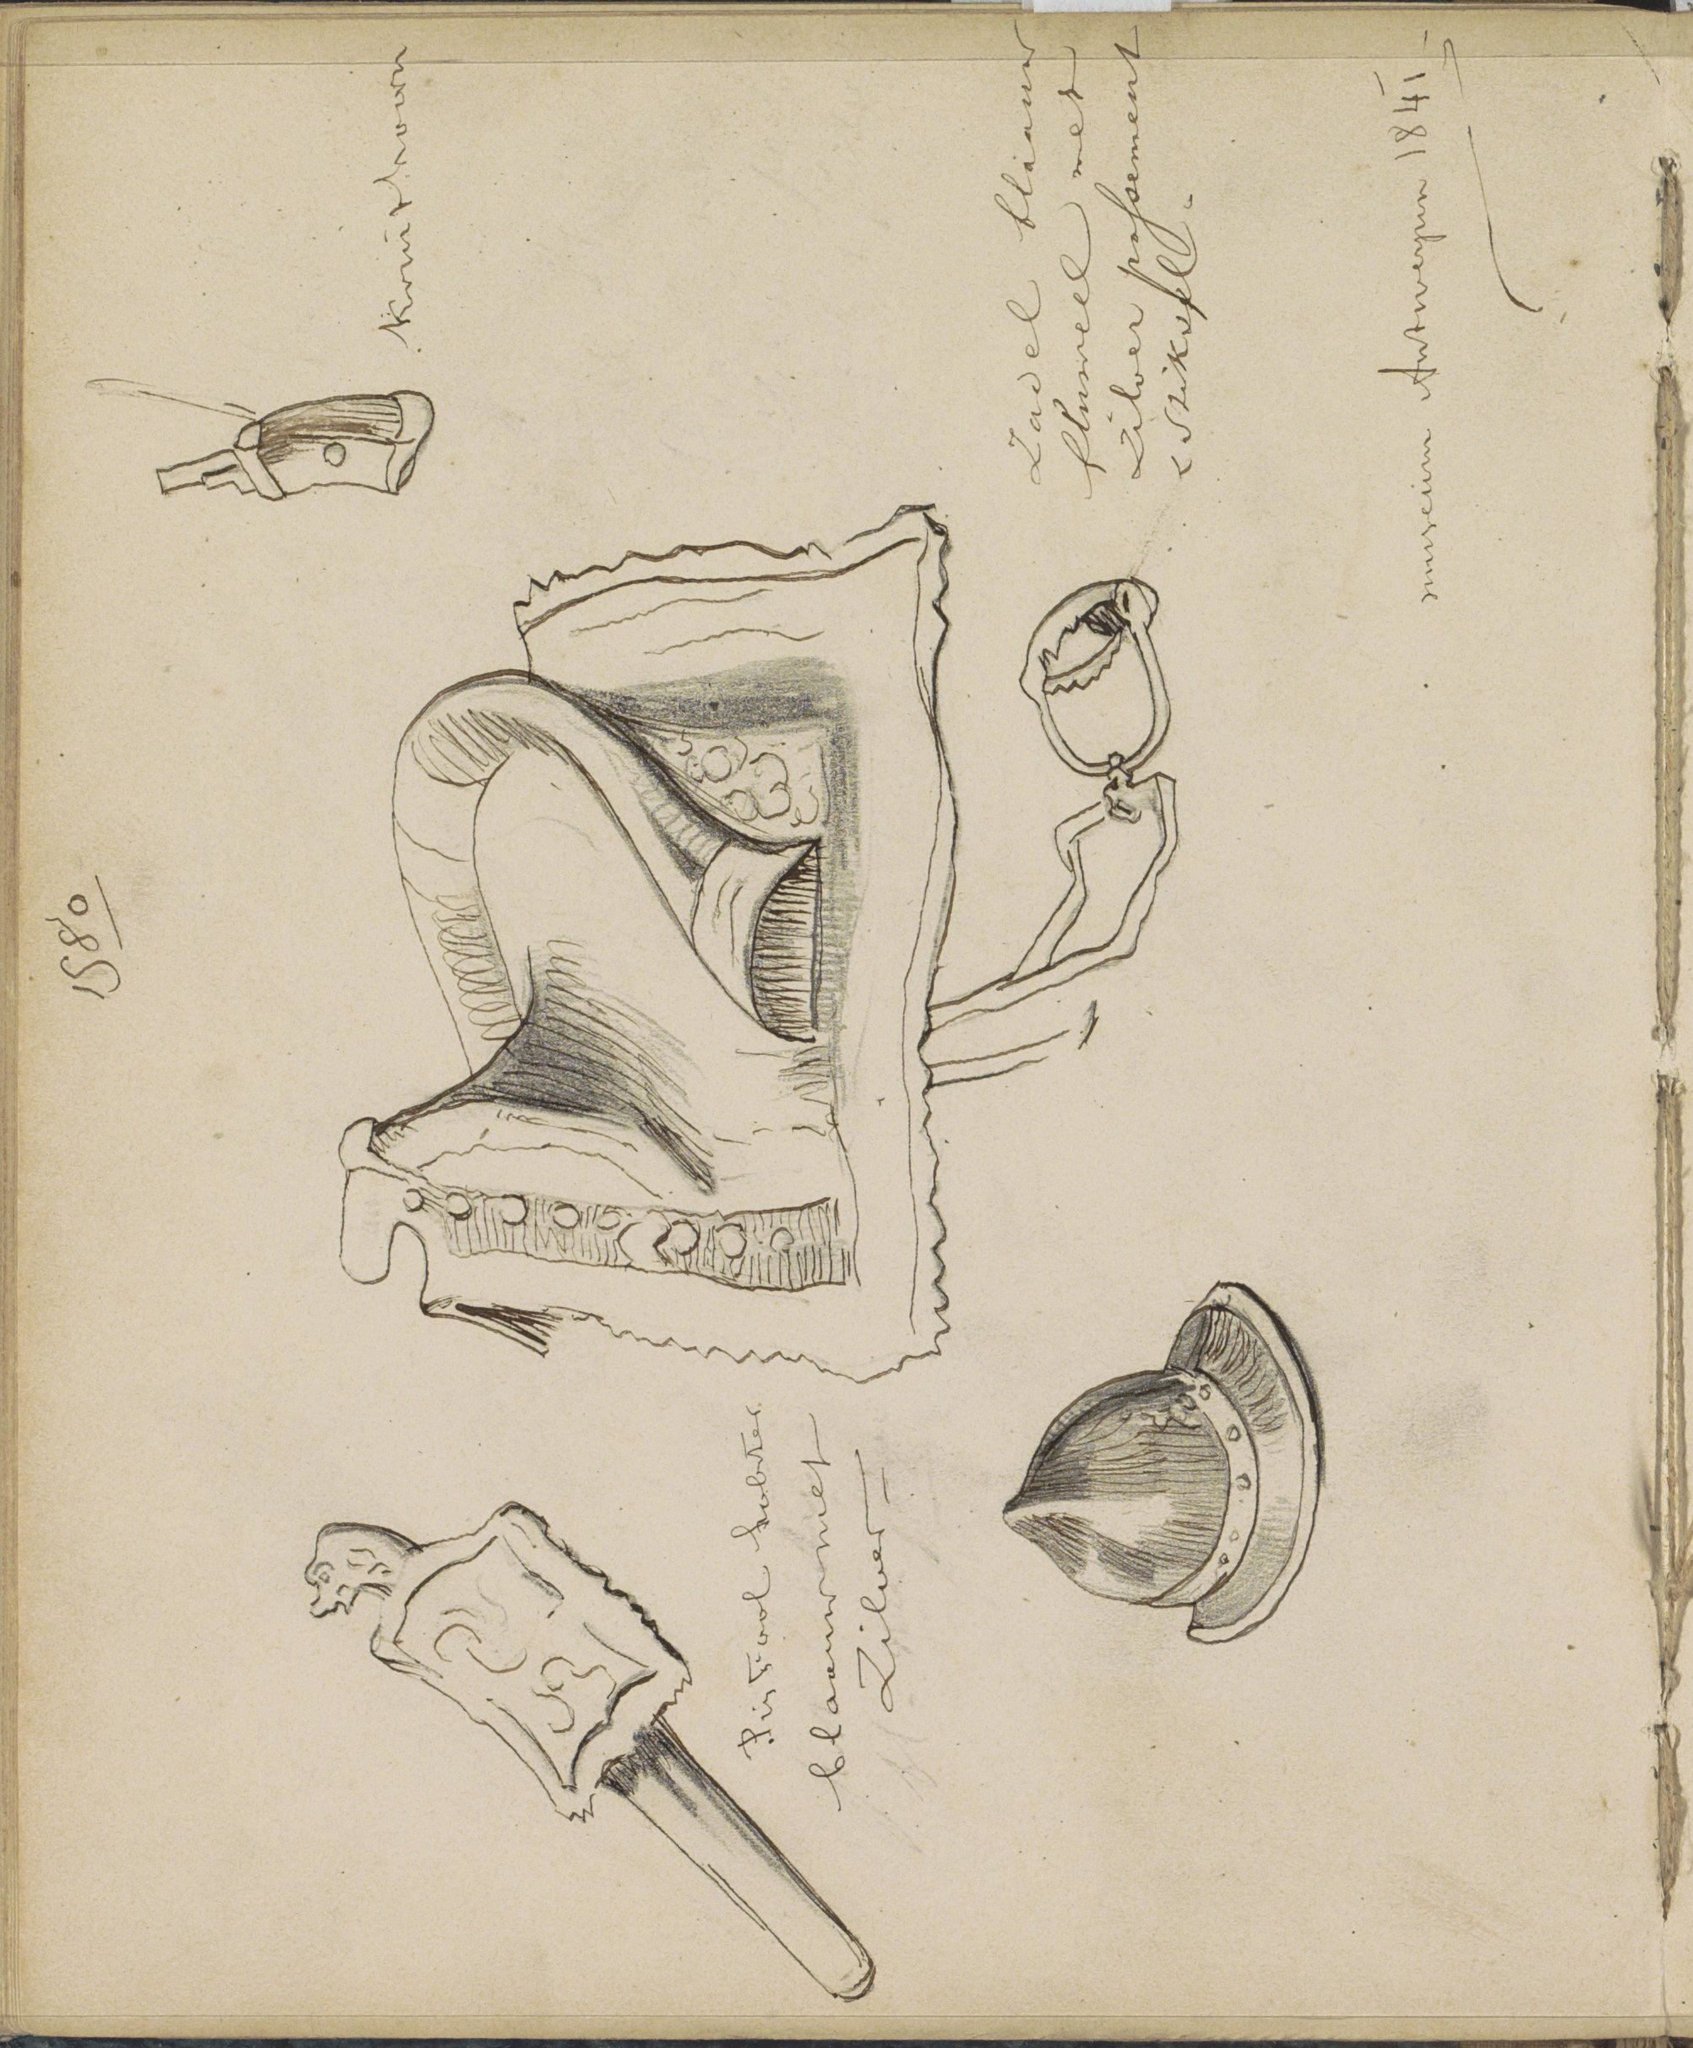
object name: sketchbook leaf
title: Pistool, zadel, kruithoorn en helm daterend uit 1580 in het Museum te Antwerpen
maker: johannes tavenraat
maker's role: draughtsman, painter, print maker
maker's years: 1809-1881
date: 1841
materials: ink, paper, pencil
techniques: pen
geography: antwerp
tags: helmet, saddle, firearms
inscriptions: date and inscription: ‘1580/ kruithoorn/ pistool [..]/ zadel [...]/ museum Antwerpen 1841 -’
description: Blad 40 verso uit een schetsboek met 87 bladen.